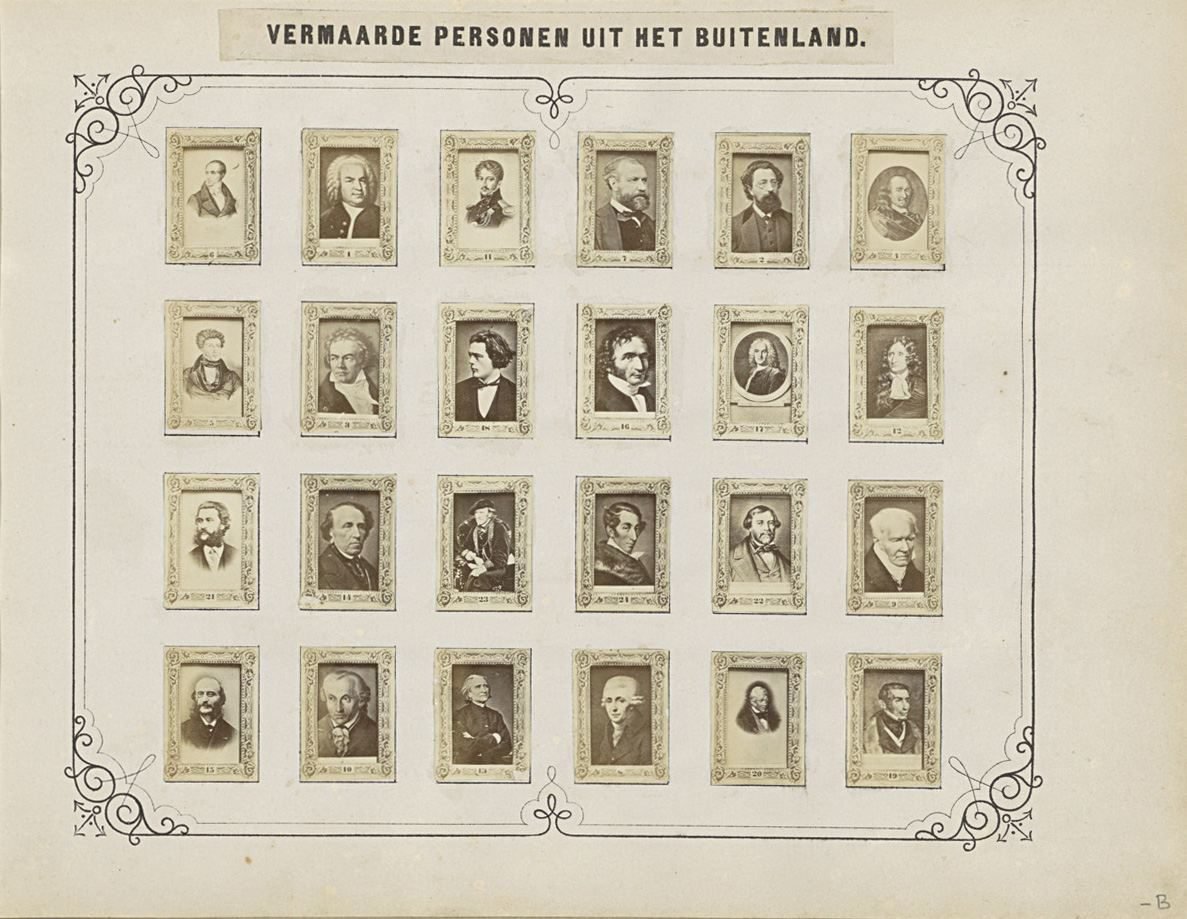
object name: photograph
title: Twee albumbladen met namen en afbeeldingen van componisten, filosofen, schrijvers en wetenschappers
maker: Anonymous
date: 1872-1875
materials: paper, photographic support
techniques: albumen print, writing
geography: haarlem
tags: vienna, richard wagner, berlin, traveler, france, paris, jean racine, pierre corneille, walter scott, scholar, philosopher, historical persons, portrait of a musician, composer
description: Onderdeel van Regnib's miniaturenalbum van vorsten, beroemdheden en historische en fantasietaferelen.